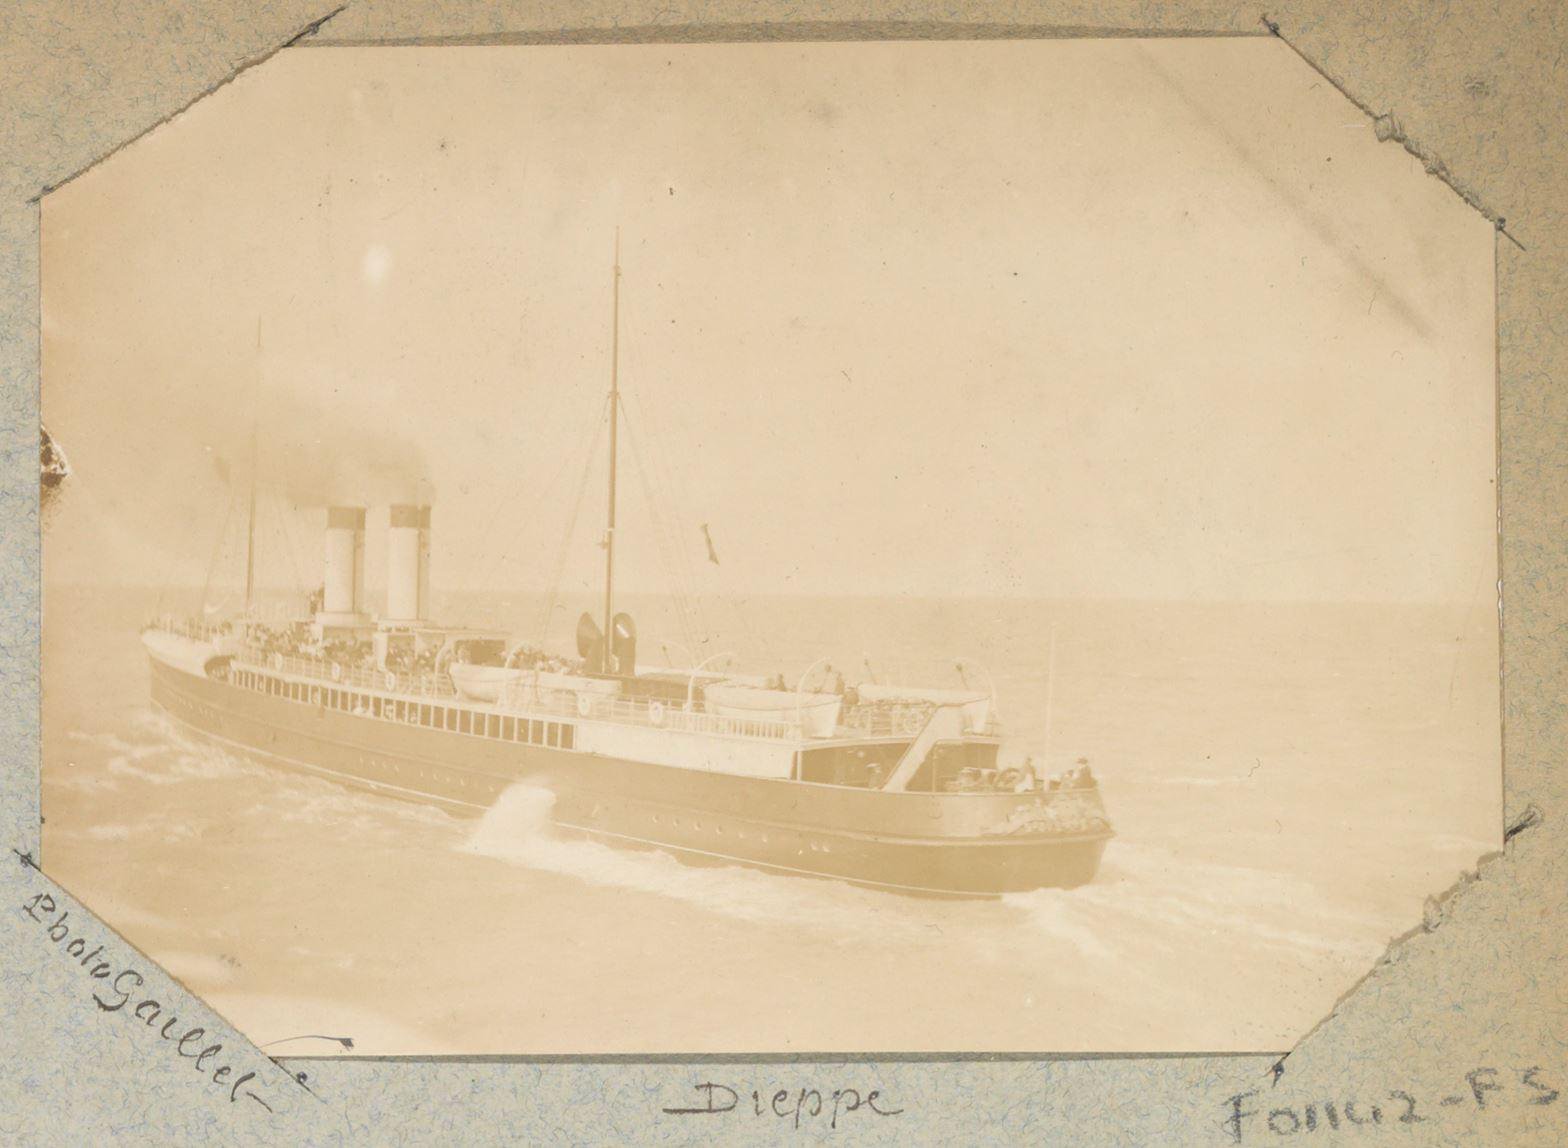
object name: album leaf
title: Schip met rokende schoorstenen varend bij Dieppe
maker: gaillet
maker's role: amateurfotograaf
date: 1890-1900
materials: paper, photographic support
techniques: daylight paper print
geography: dieppe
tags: steamship, motorship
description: Onderdeel van Album van een Franse amateur met foto's van Frankrijk, Algerije, Palmyra, de Wereldtentoonstelling van 1900 en van bekende Fransen.